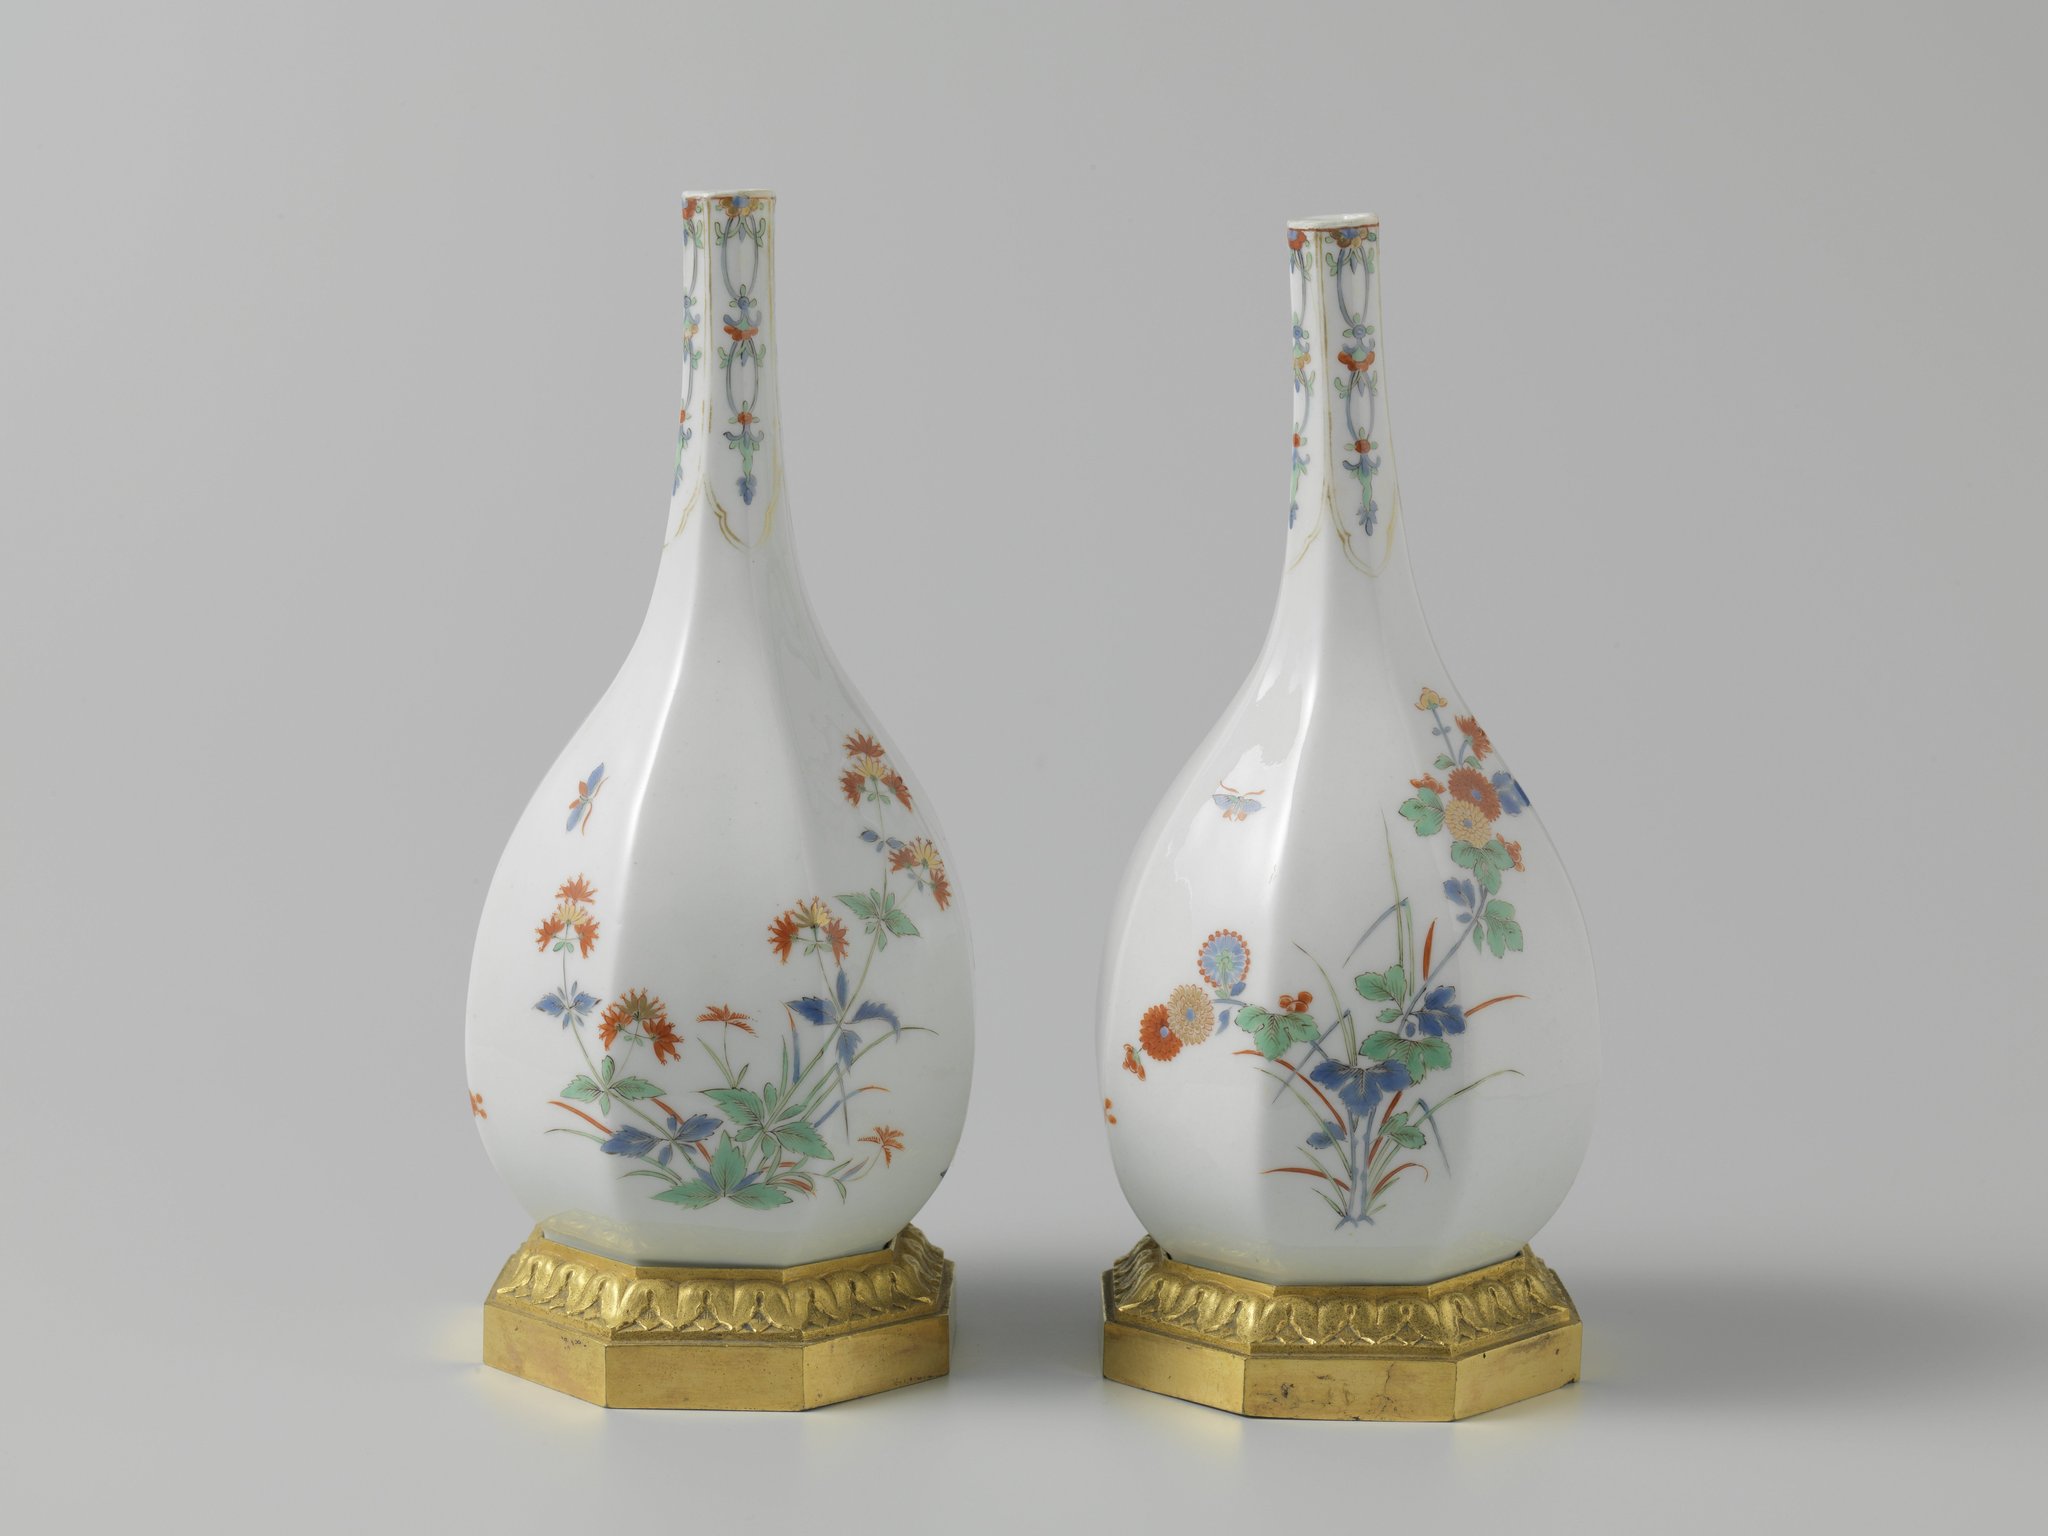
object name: decoratief object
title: Fles, veelkleurig beschilderd met een Kakiemon-decor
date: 1730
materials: porcelain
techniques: painted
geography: meissen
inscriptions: factory mark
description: Achthoekige fles van beschilderd porselein en een verguld bronzen montuur. De vaas heeft een slanke hals en is aan beide zijden beschilderd met bloeiende planten in kakiemon-stijl. De vaas is gemerkt.